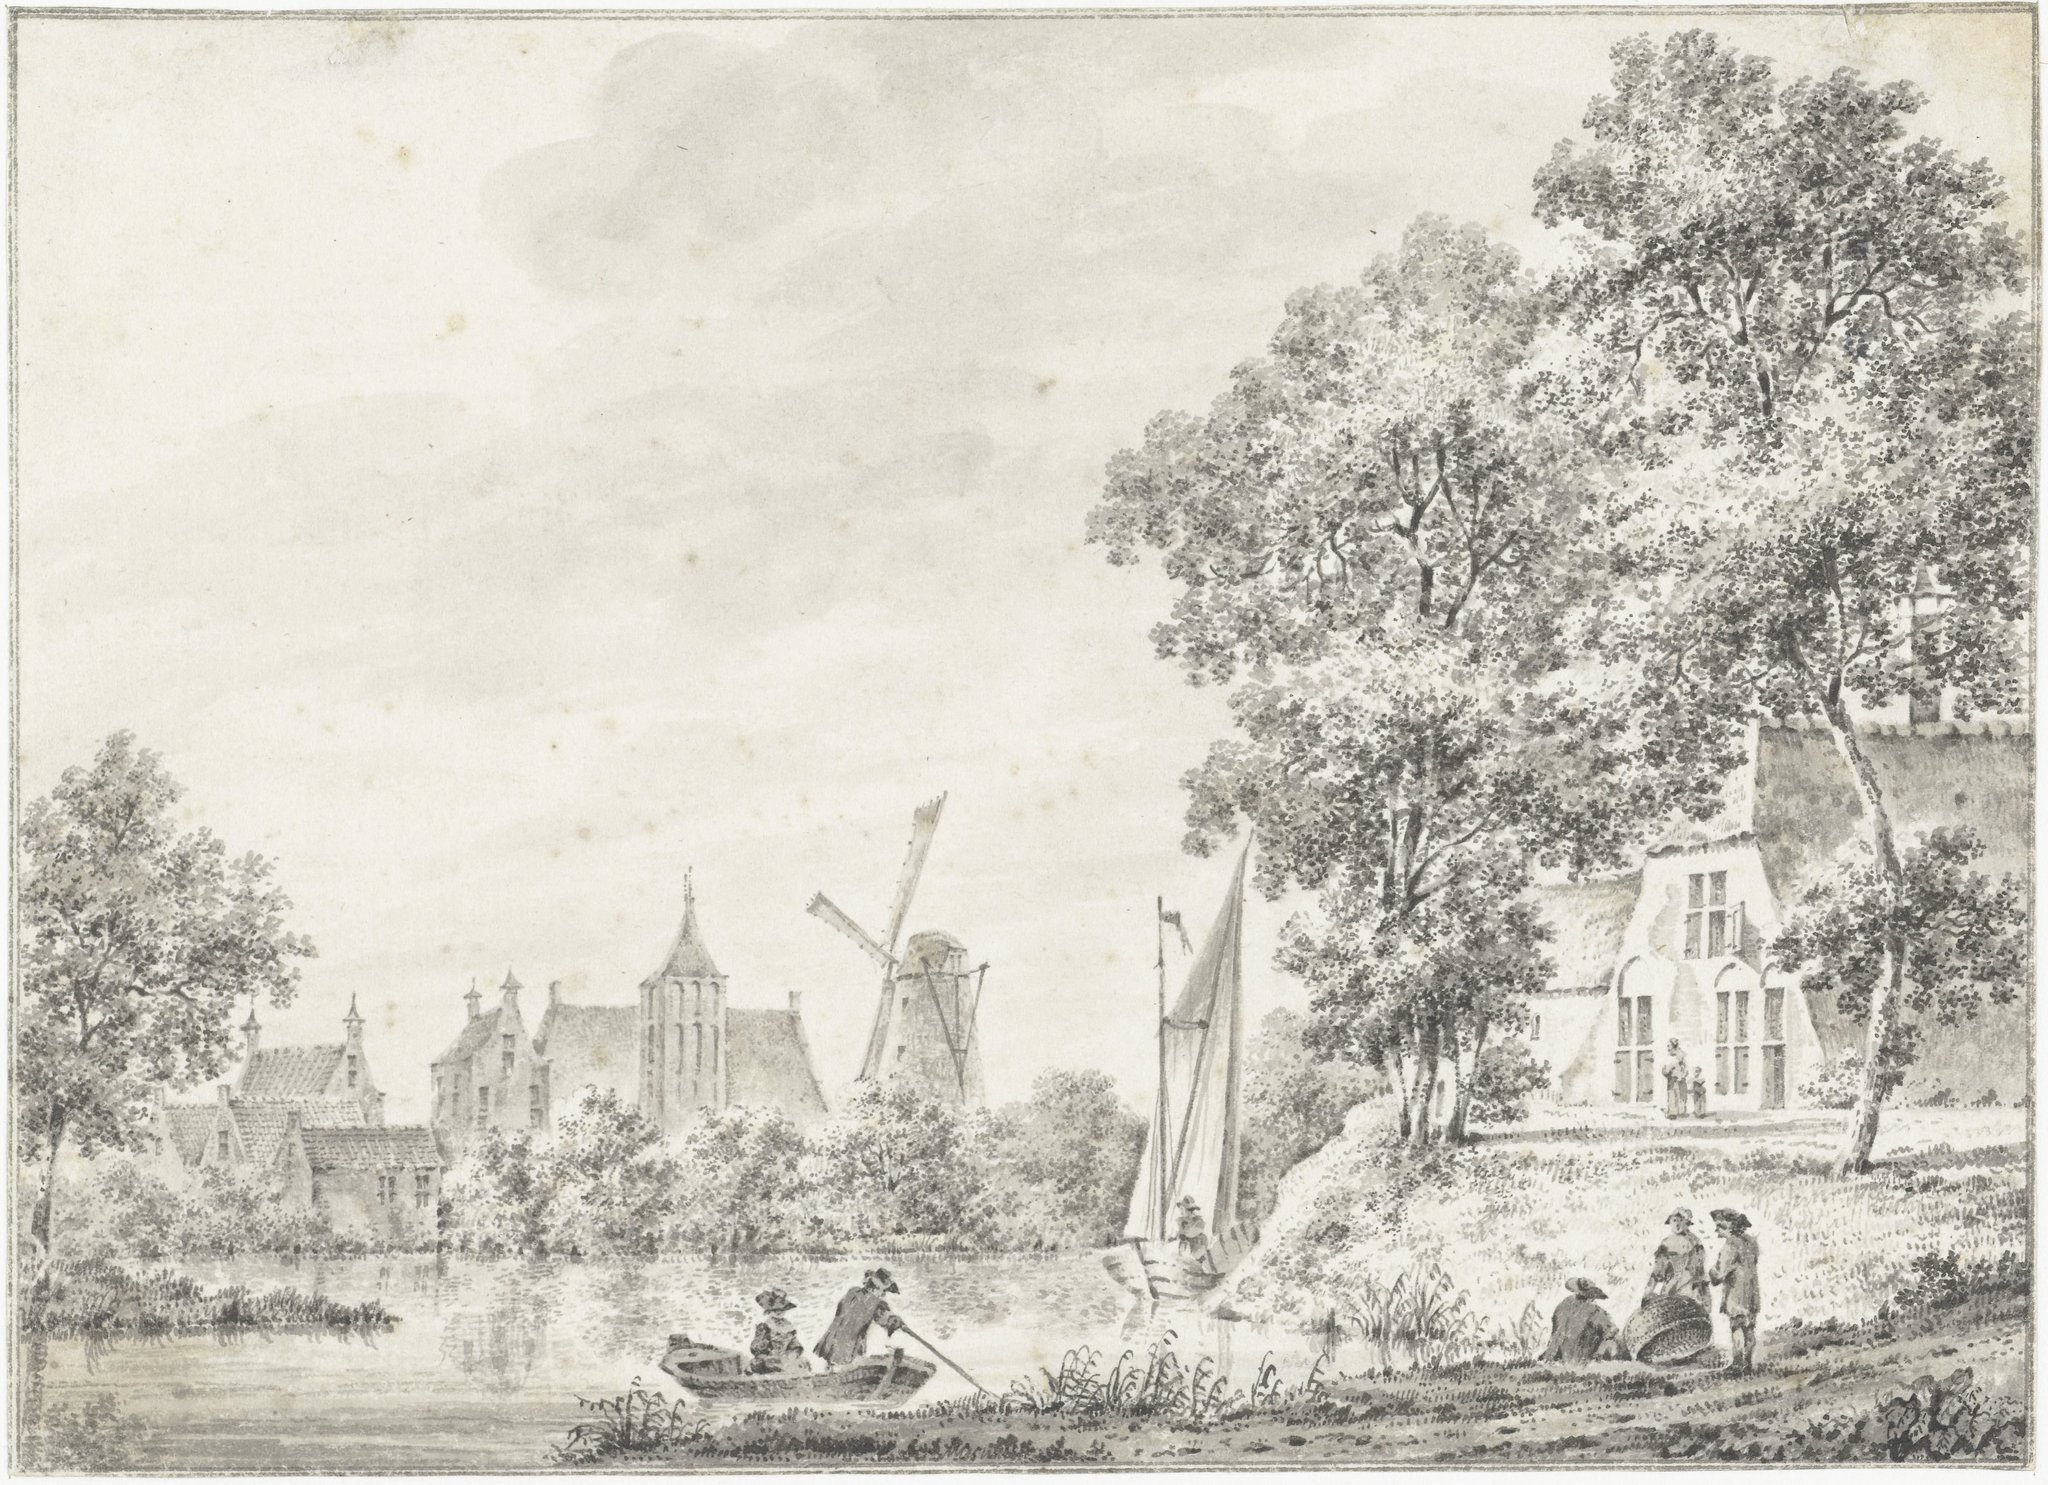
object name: drawing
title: Gezicht te Haastrecht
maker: pieter jan van liender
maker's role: print maker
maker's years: 1727-1779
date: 1763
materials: ink, paper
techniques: brush, pen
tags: prospect of village, silhouette of village